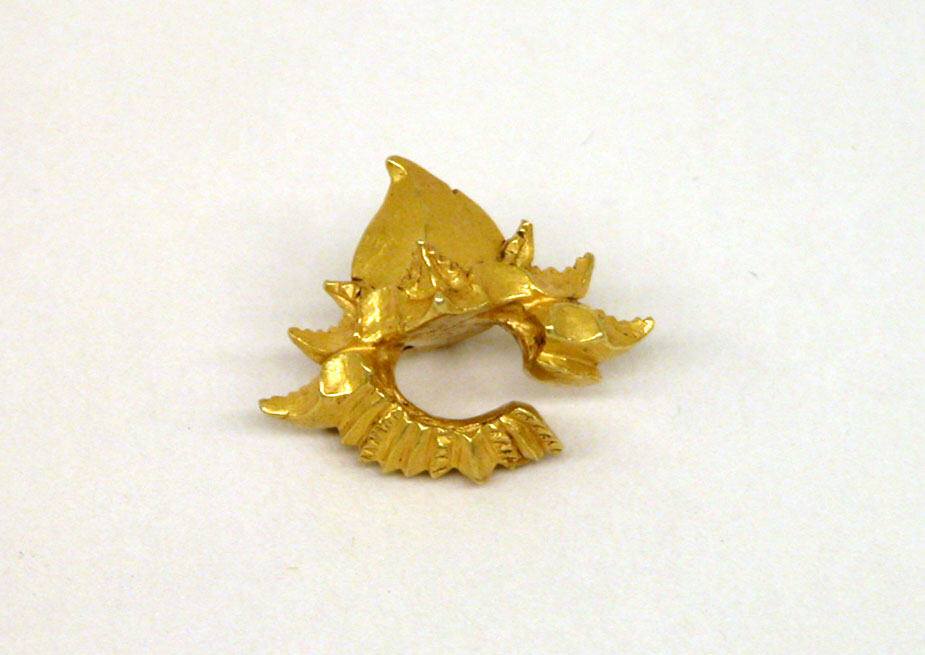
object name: ear ornament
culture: indonesian, javanese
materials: gold